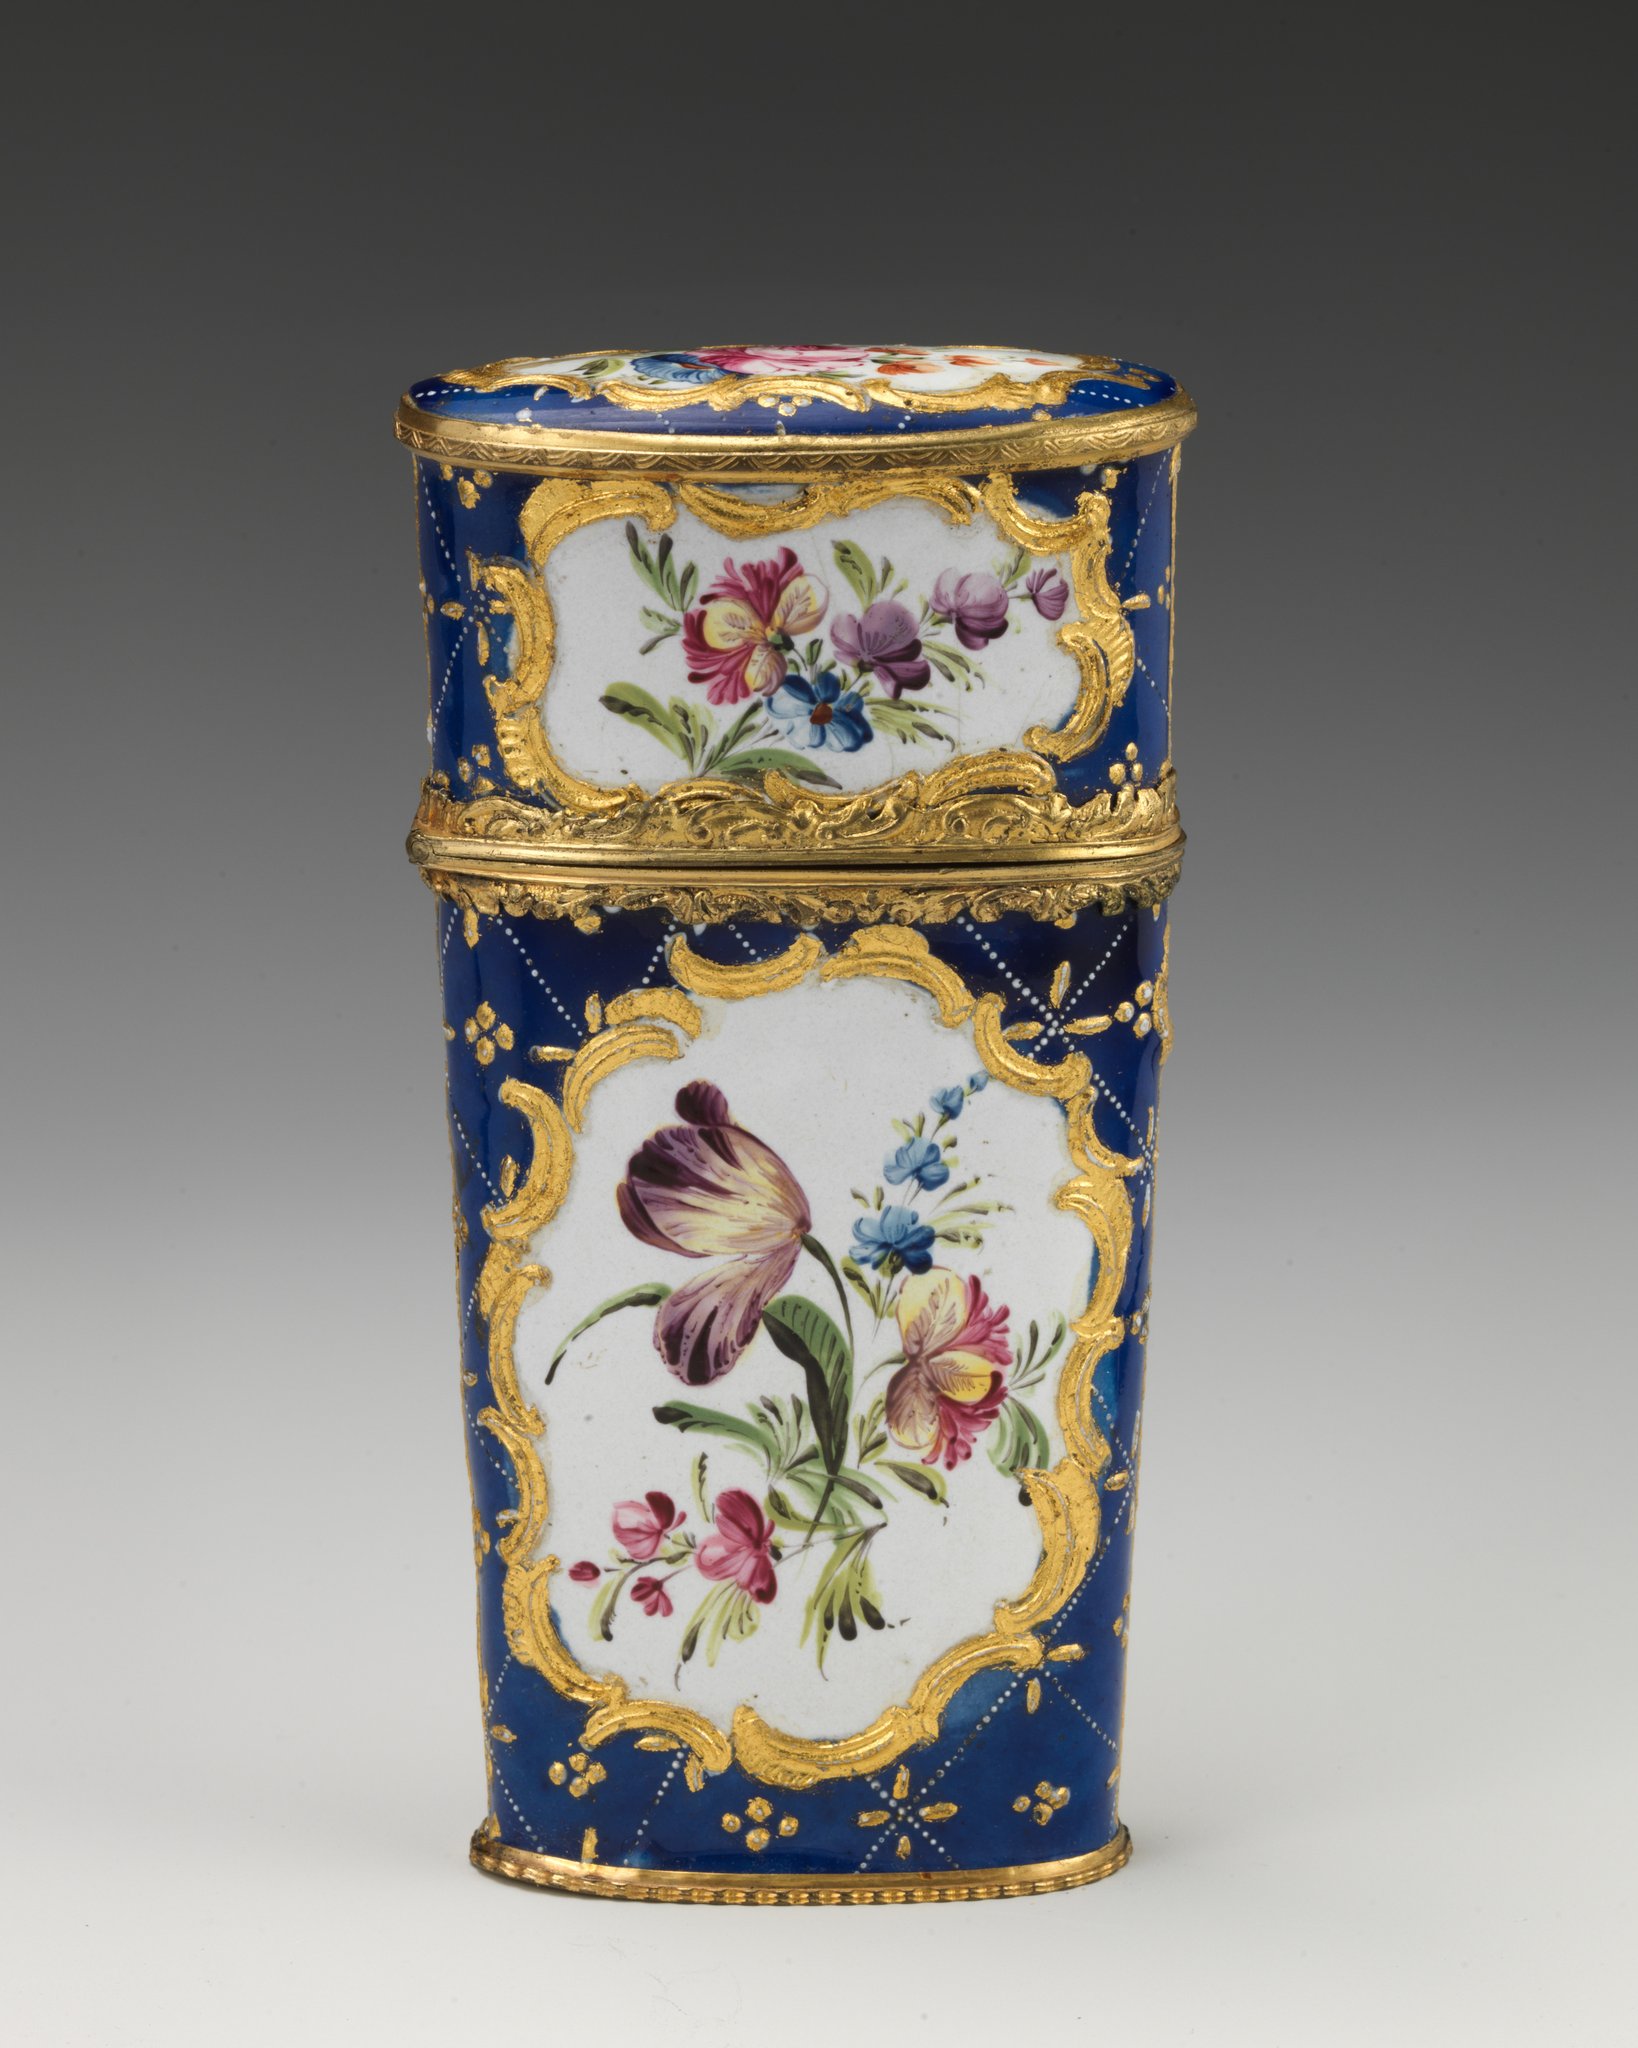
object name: étui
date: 1765-1770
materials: copper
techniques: enamel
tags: flowers